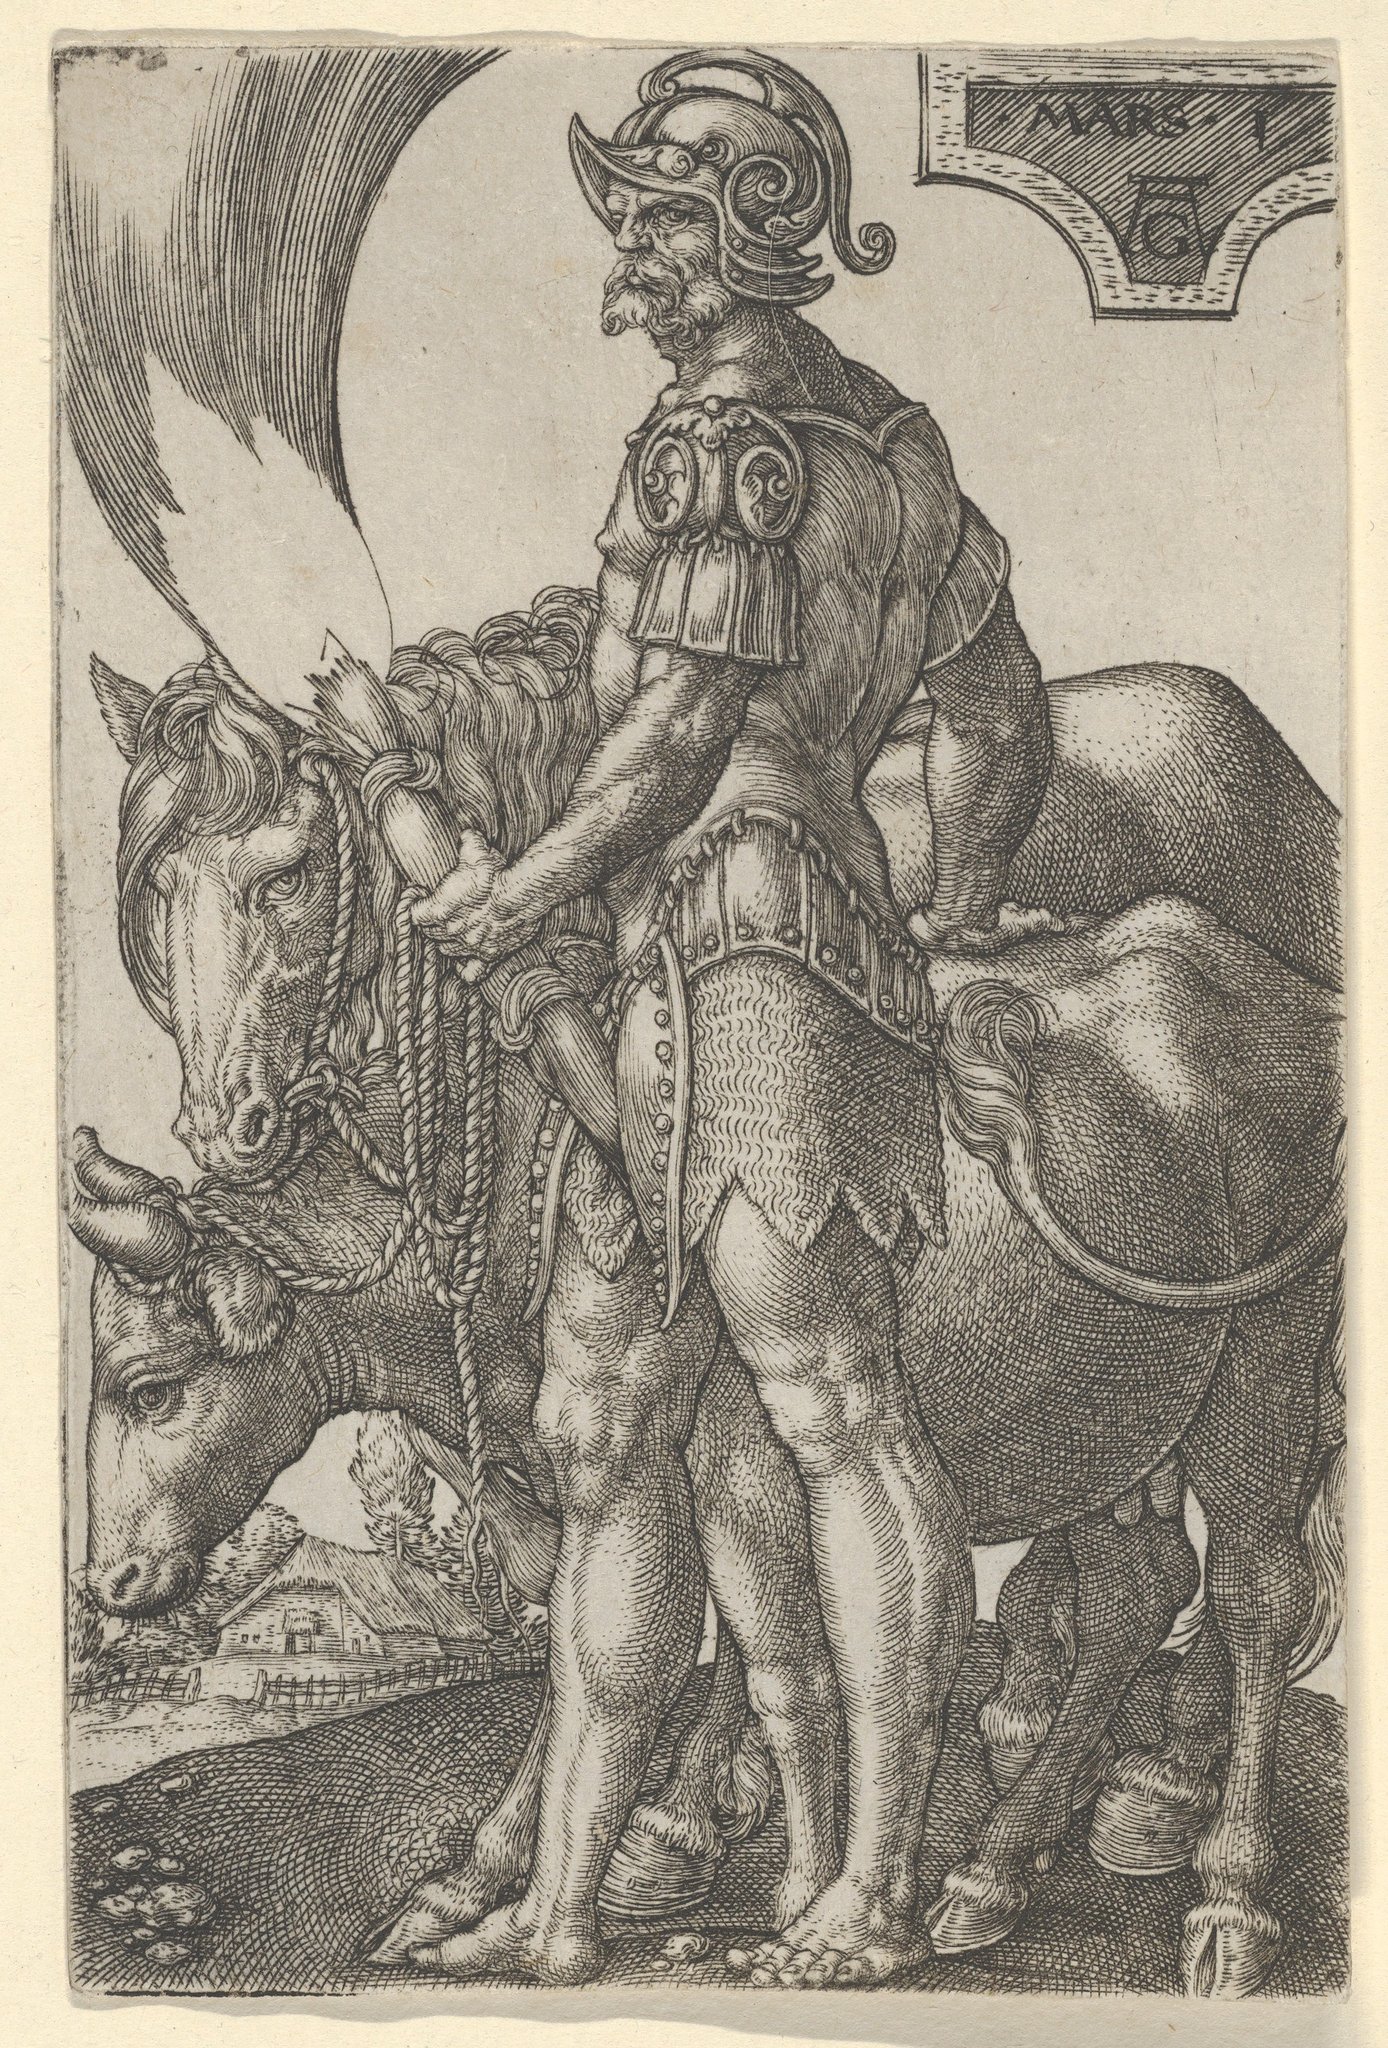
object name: print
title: Mars, from The Seven Planets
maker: heinrich aldegrever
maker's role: artist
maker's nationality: german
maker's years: 1502-1561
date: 1533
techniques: engraving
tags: mars,cows,horses